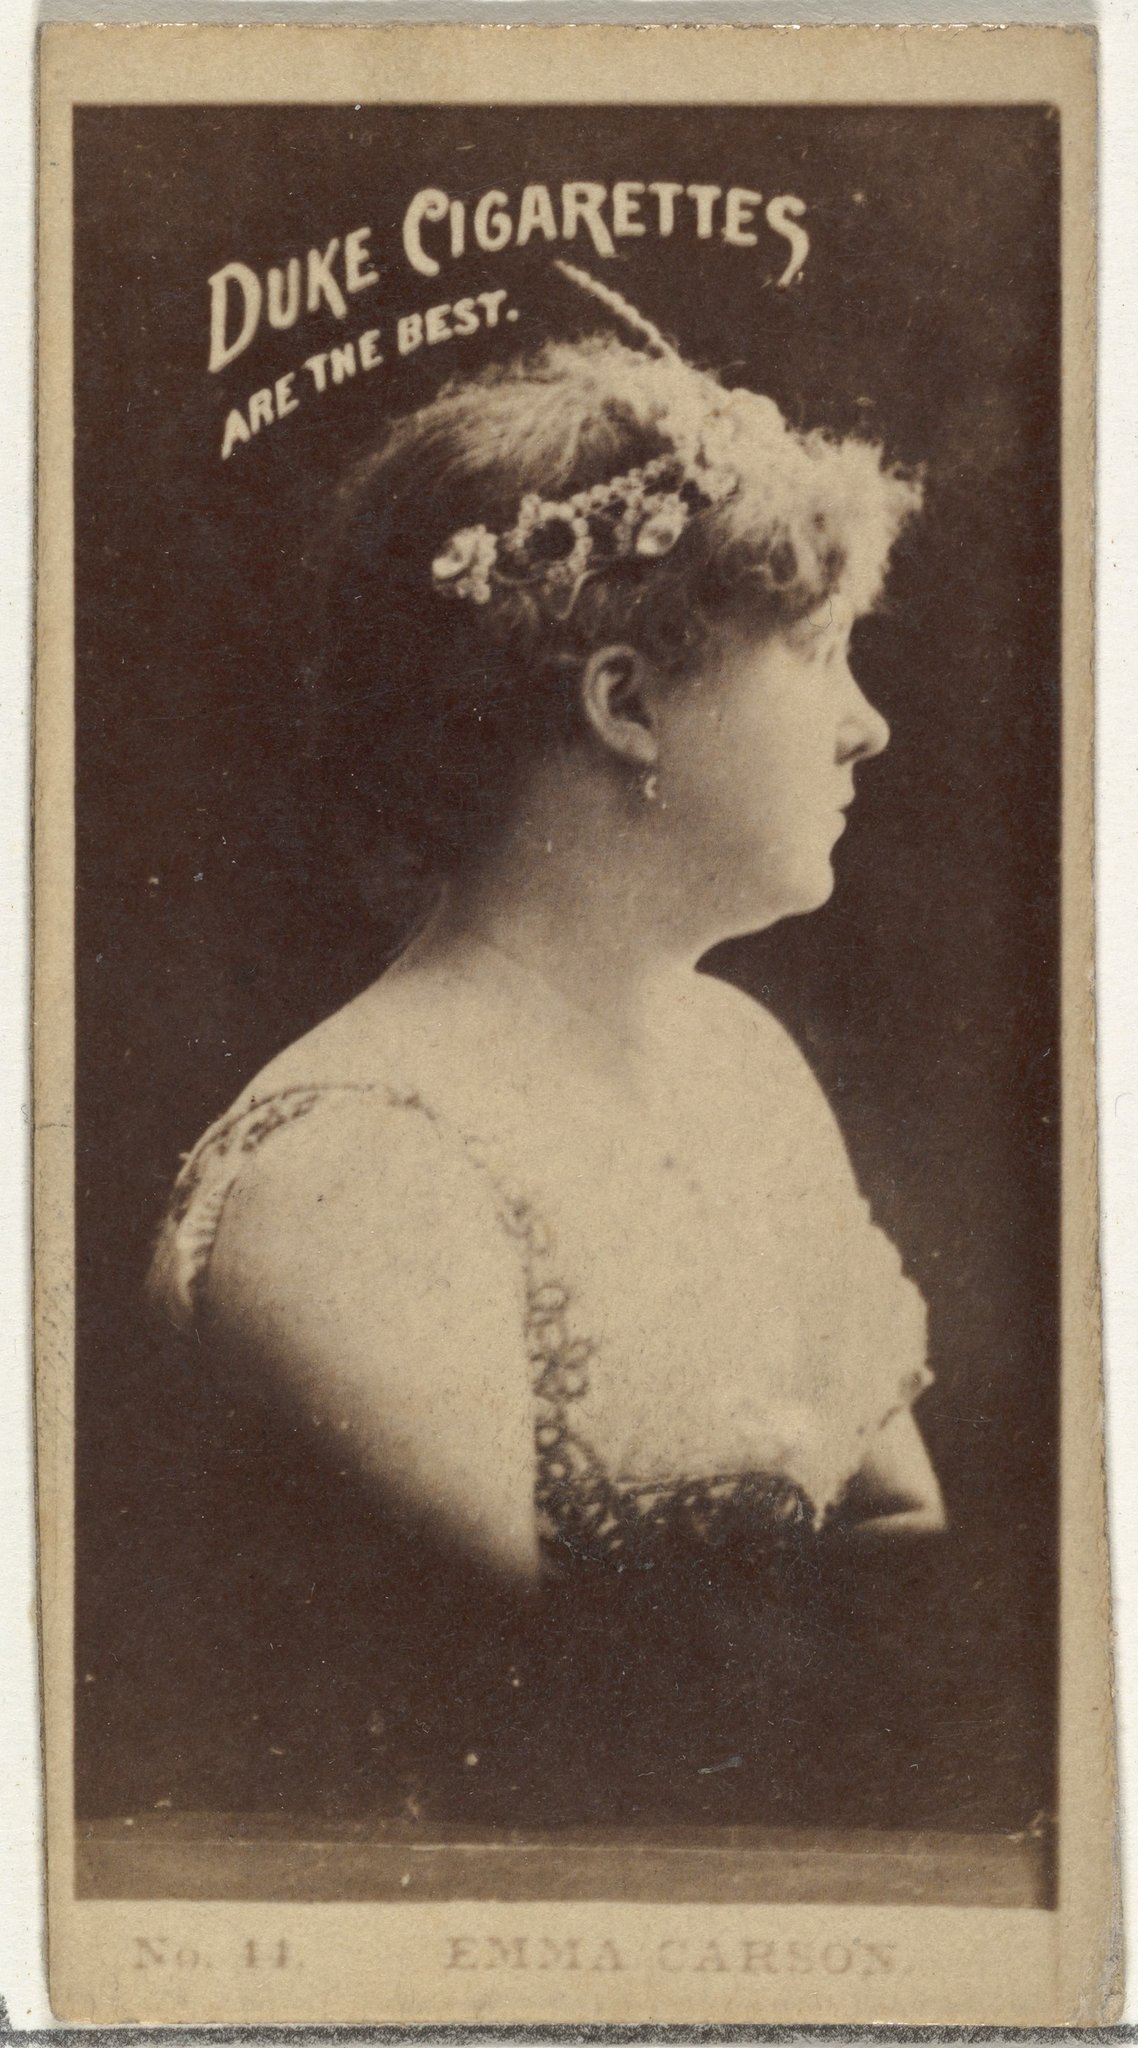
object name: photograph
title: Card Number 14, Emma Carson, from the Actors and Actresses series (N145-6) issued by Duke Sons & Co. to promote Duke Cigarettes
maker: w. duke, sons & co.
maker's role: publisher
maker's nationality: american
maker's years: 1870-1920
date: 1880-1889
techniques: albumen silver print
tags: women,actresses